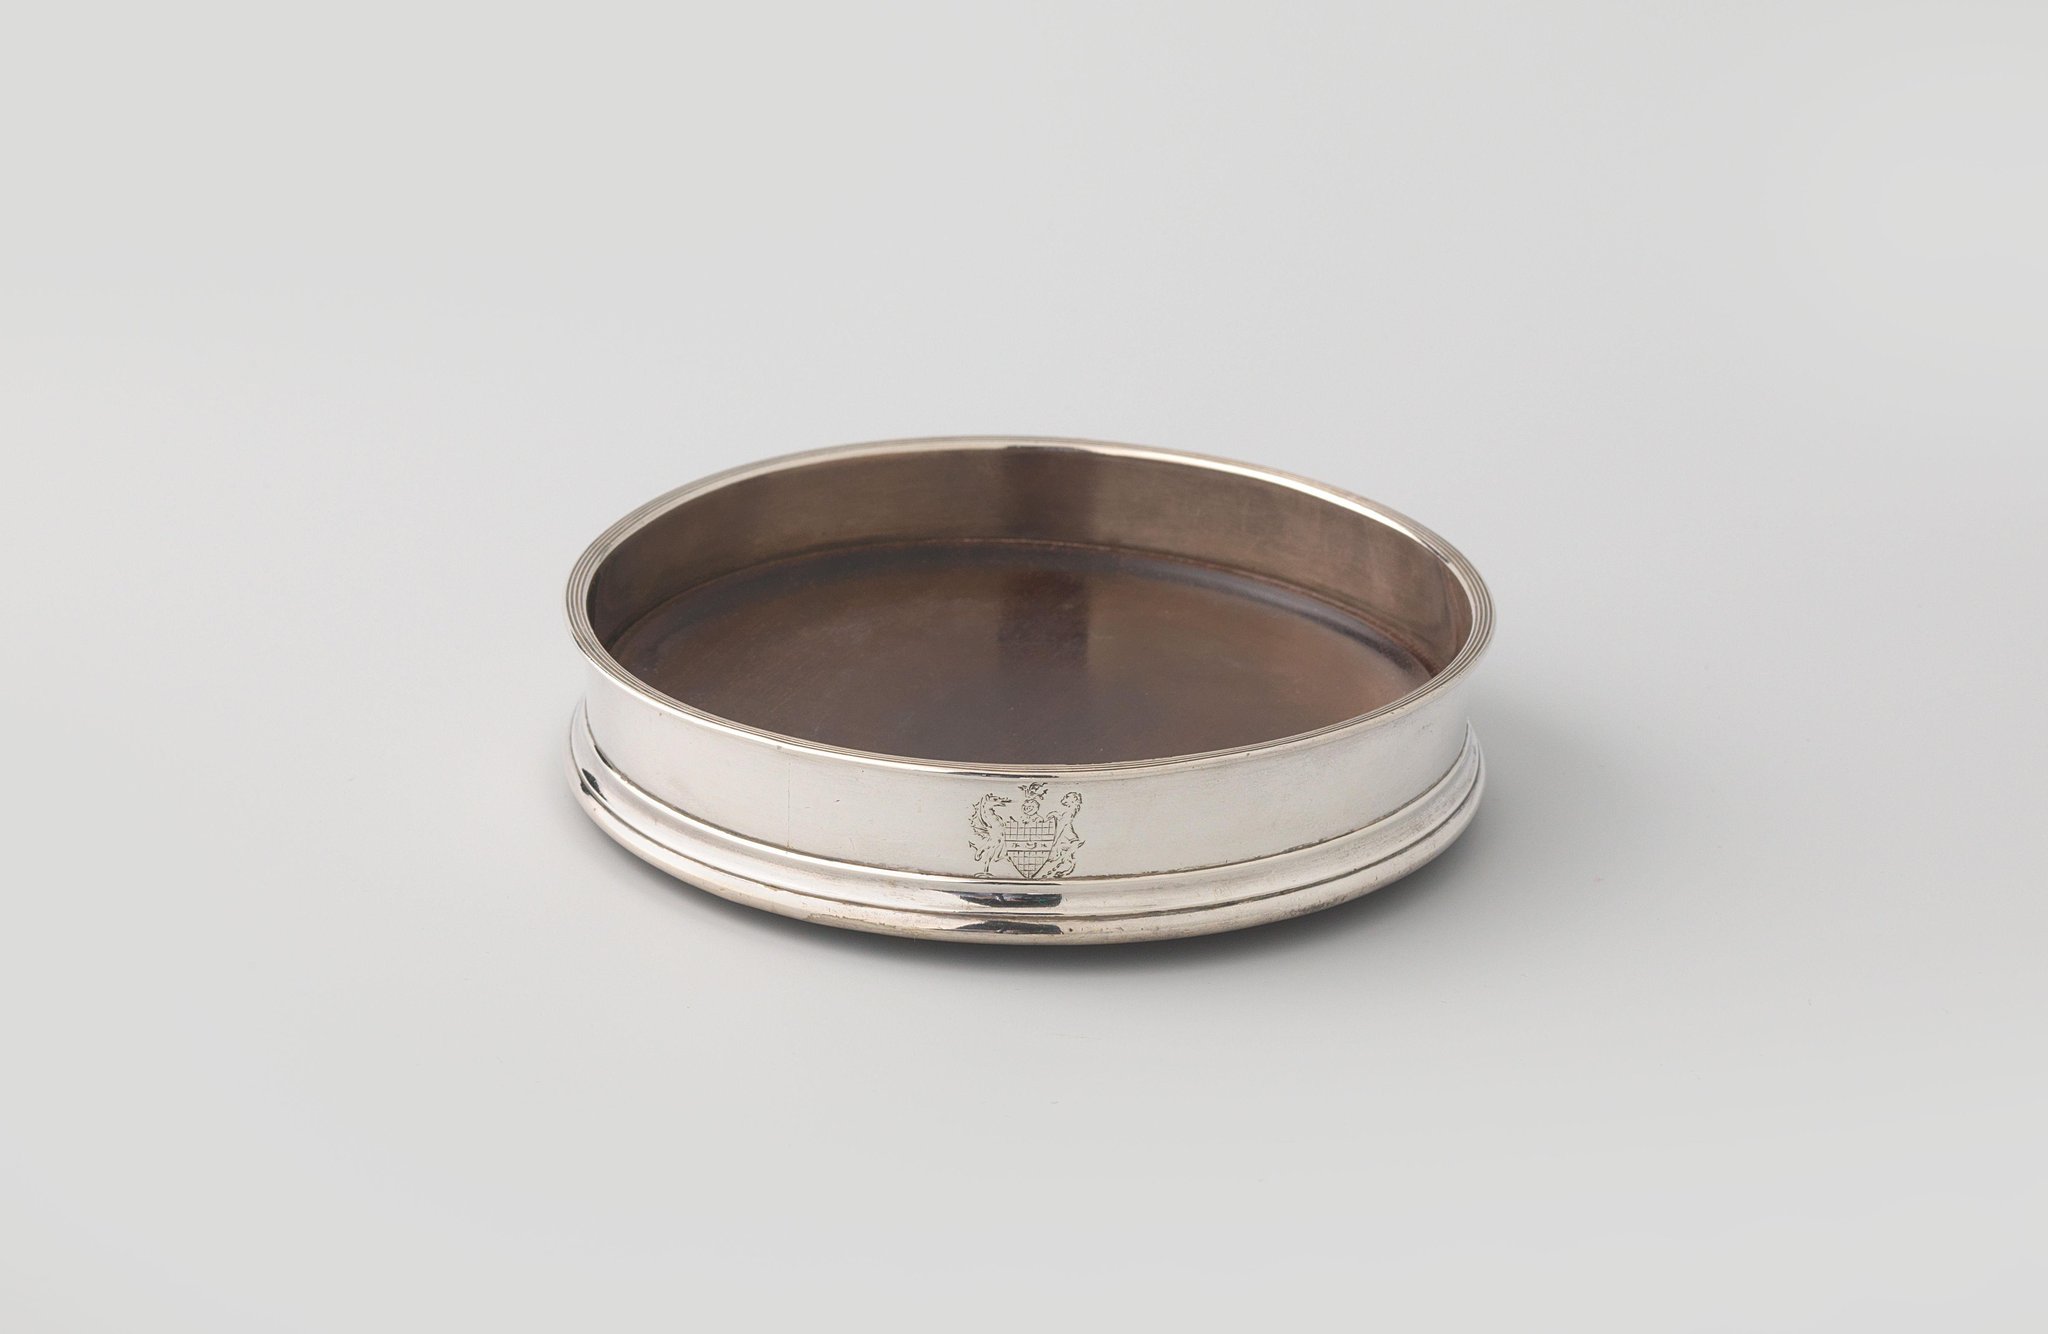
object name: wine coaster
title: Flessenbak met het familiewapen Clifford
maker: diederik lodewijk bennewitz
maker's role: silversmith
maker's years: 1763-1826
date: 1806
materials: wood, silver, velvet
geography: amsterdam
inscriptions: alloy mark, maker's mark, town mark, date letter: ‘X’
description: De wand van de ronde flessenbak heeft een geprofileerde, zich verjongende onderrand en een liggende bovenrand met filetversiering. In de onderrand is de mahoniehouten bodem gevat. De bak is aan de onderzijde bekleed met groen fluweel. Op de wand is het wapen Clifford met het helmteken en schildhouders gegraveerd.